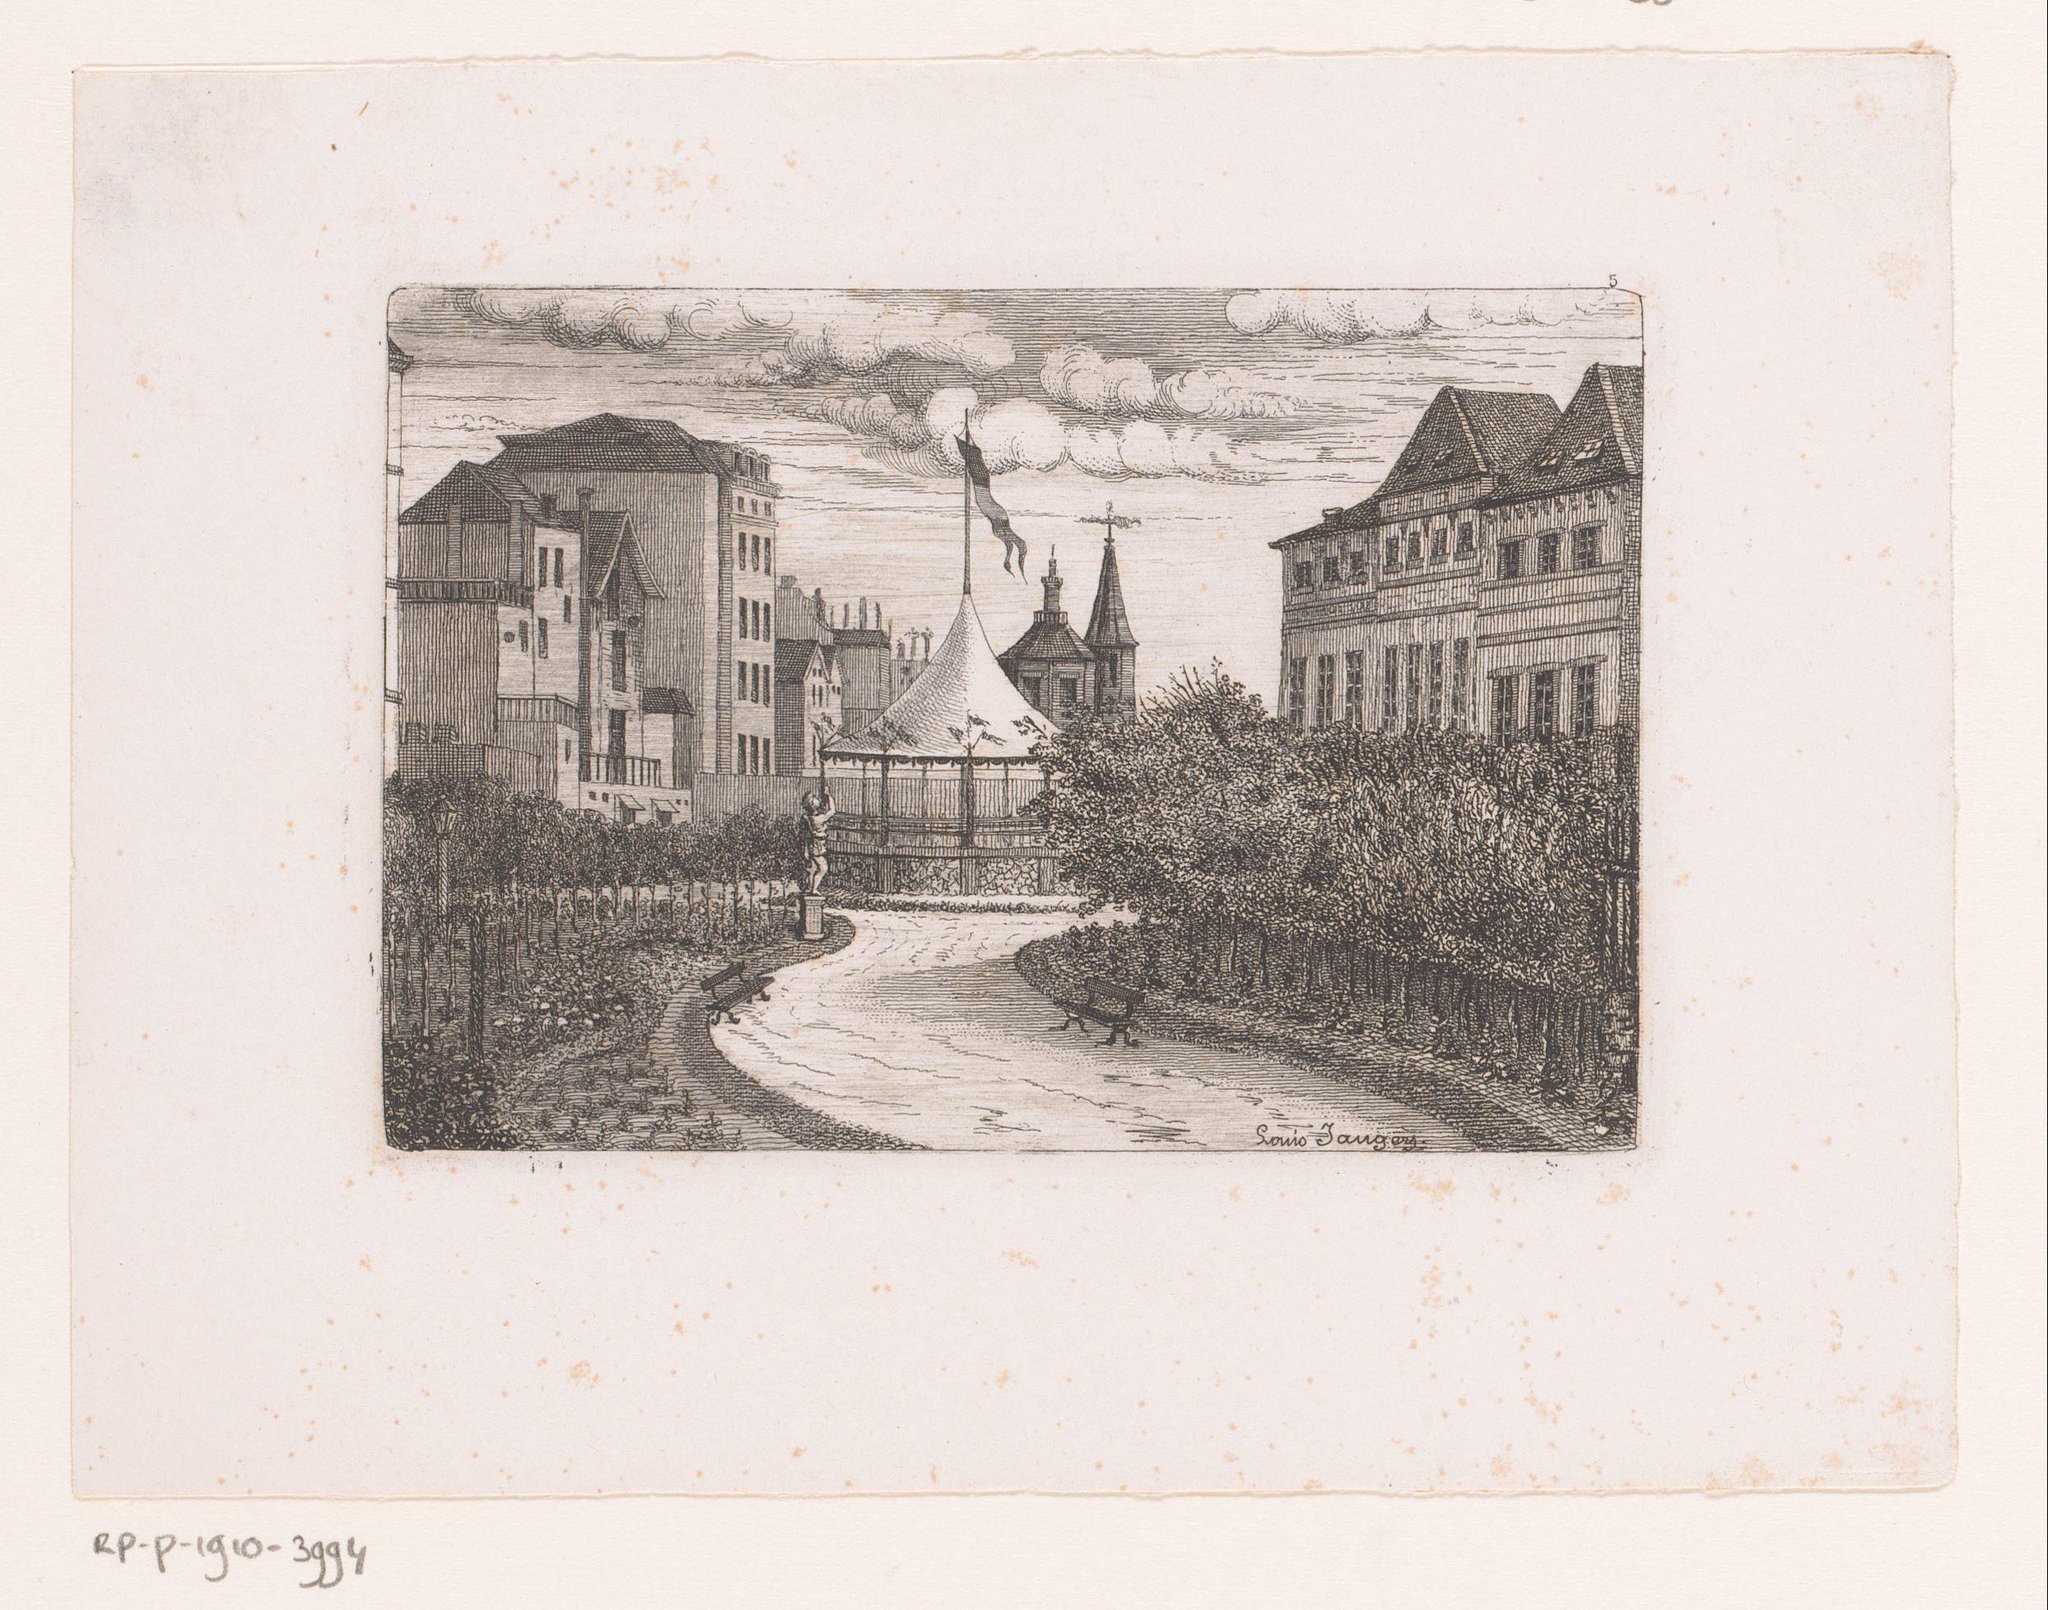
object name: print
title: Souvenir de Blankenberghe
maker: louis jaugey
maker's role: print maker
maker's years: 1837-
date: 1850-1899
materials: paper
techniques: etching, intaglio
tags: summer-house, arbour, garden-house (dutch: 'theekoepel'), public gardens, park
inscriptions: collector's mark: Lugt 2228